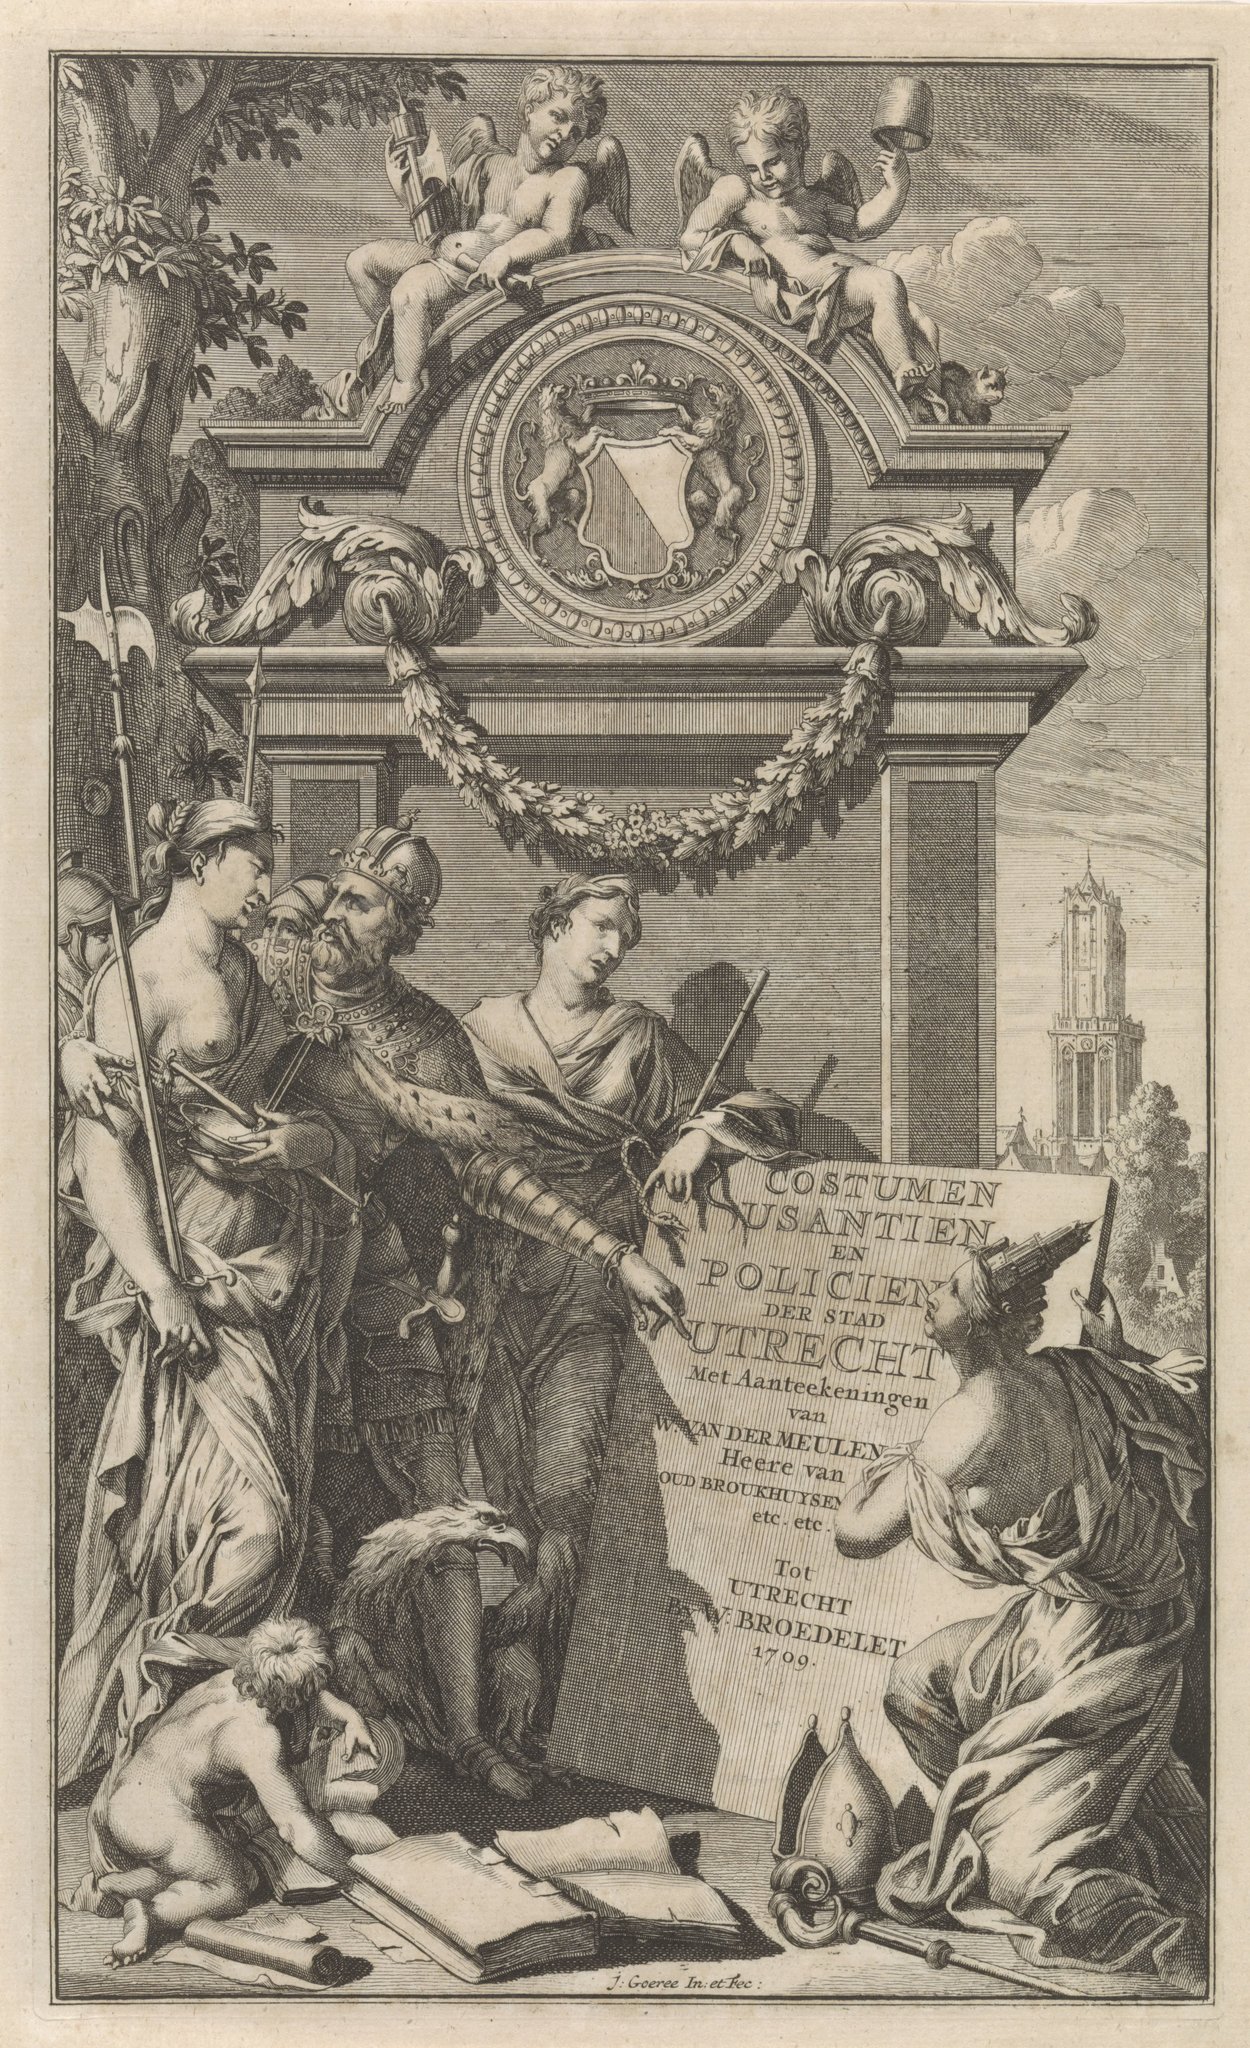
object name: print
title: Costumen Usantien en Policien der stad Utrecht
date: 1709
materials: paper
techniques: engraving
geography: amsterdam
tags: justice, 'justitia'; 'giustitia divina' (ripa) ~ one of the four cardinal virtues, prudence, 'prudentia'; 'prudenza' (ripa) ~ one of the four cardinal virtues, emperor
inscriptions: collector's mark: Lugt 2228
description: De Duitse keizer toont de personificatie Rechtvaardigheid een bord met de titel van het boekwerk. Naast het bord de stadsmaagd Utrecht en de personificatie Voorzichtigheid. Op de achtergrond de Dom van Utrecht